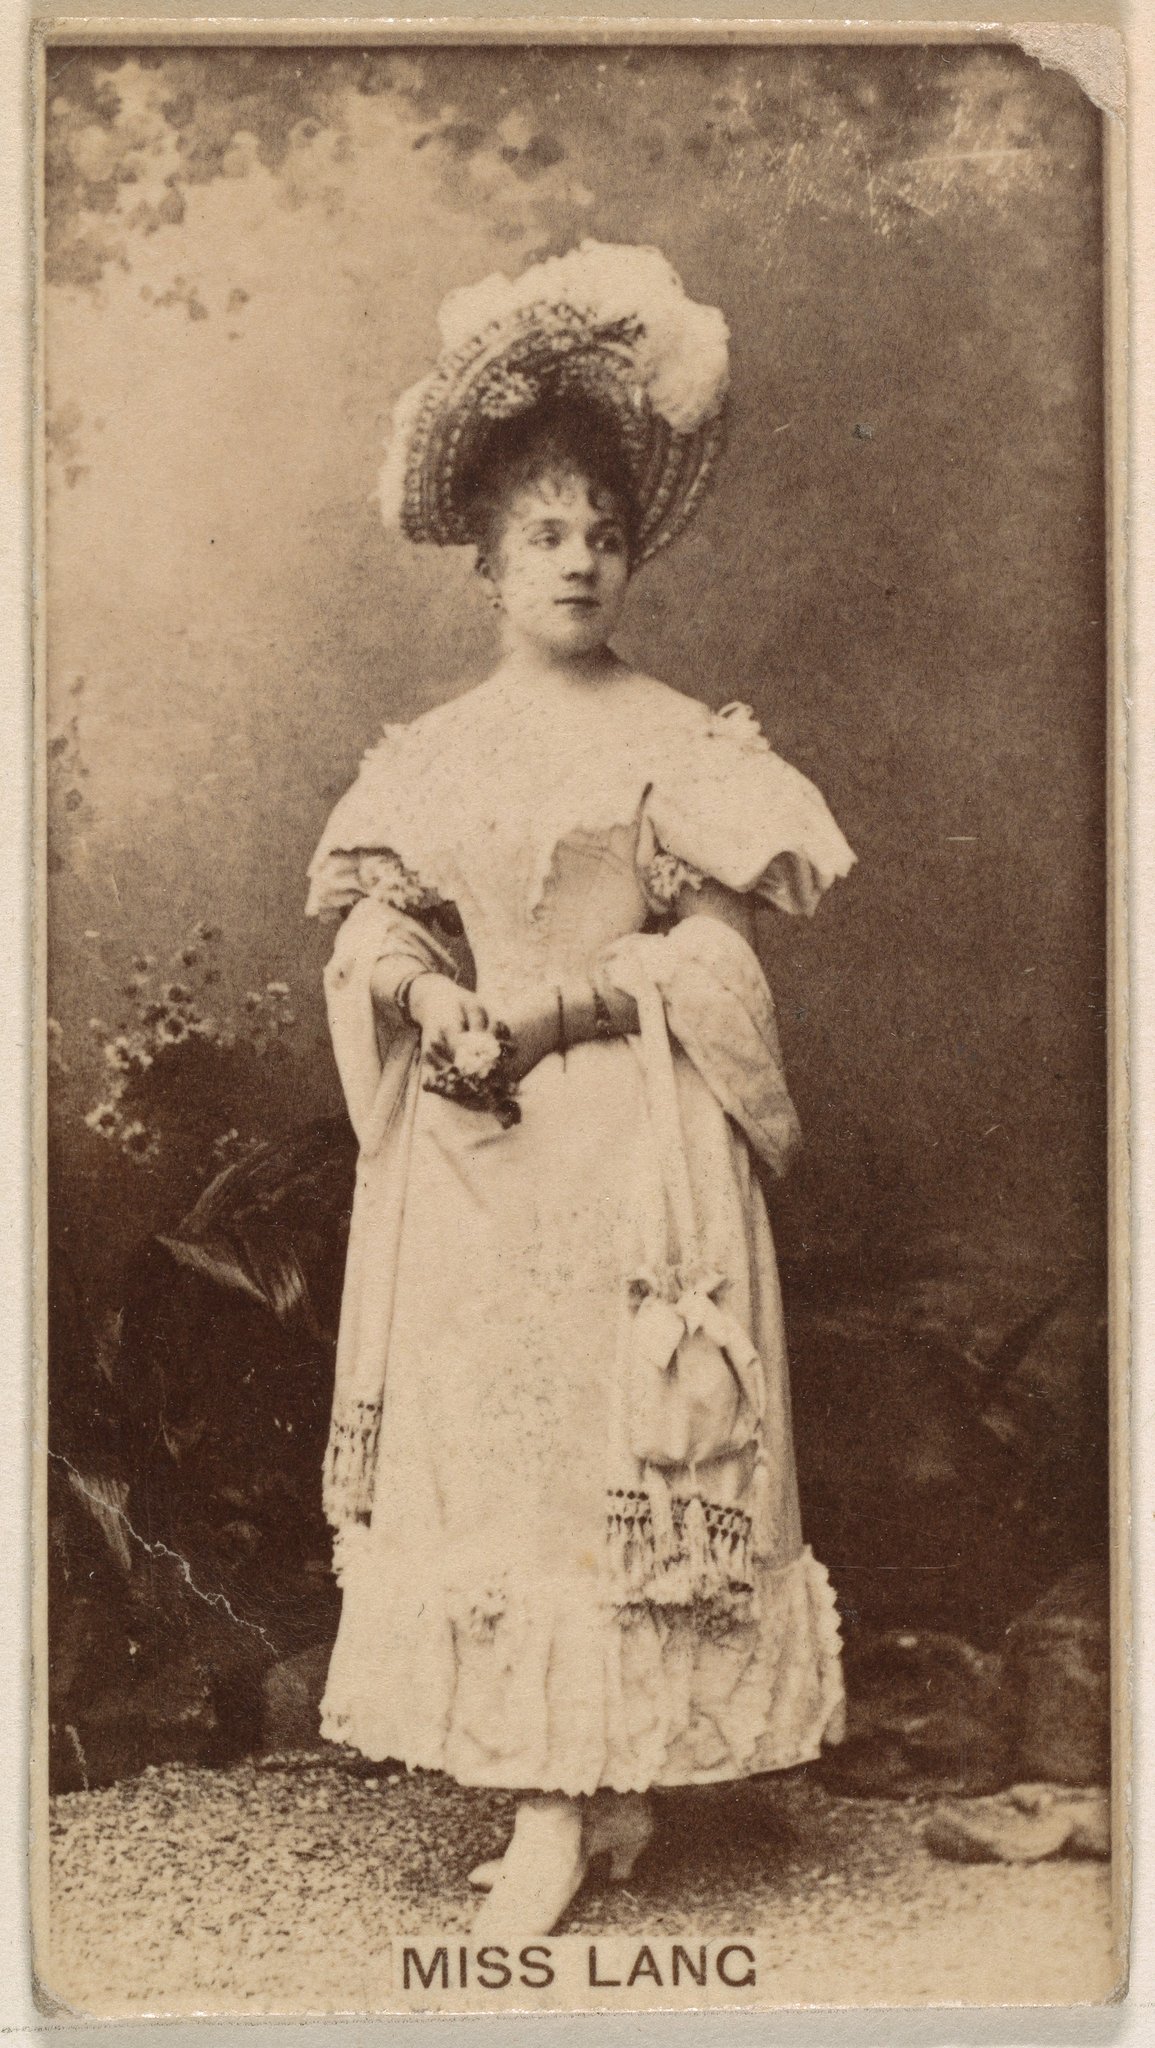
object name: photograph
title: Miss Lang, from the Actresses series (N245) issued by Kinney Brothers to promote Sweet Caporal Cigarettes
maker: kinney brothers tobacco company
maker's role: publisher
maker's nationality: american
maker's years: 1869-2011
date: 1890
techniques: albumen silver print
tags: portraits,women,actresses